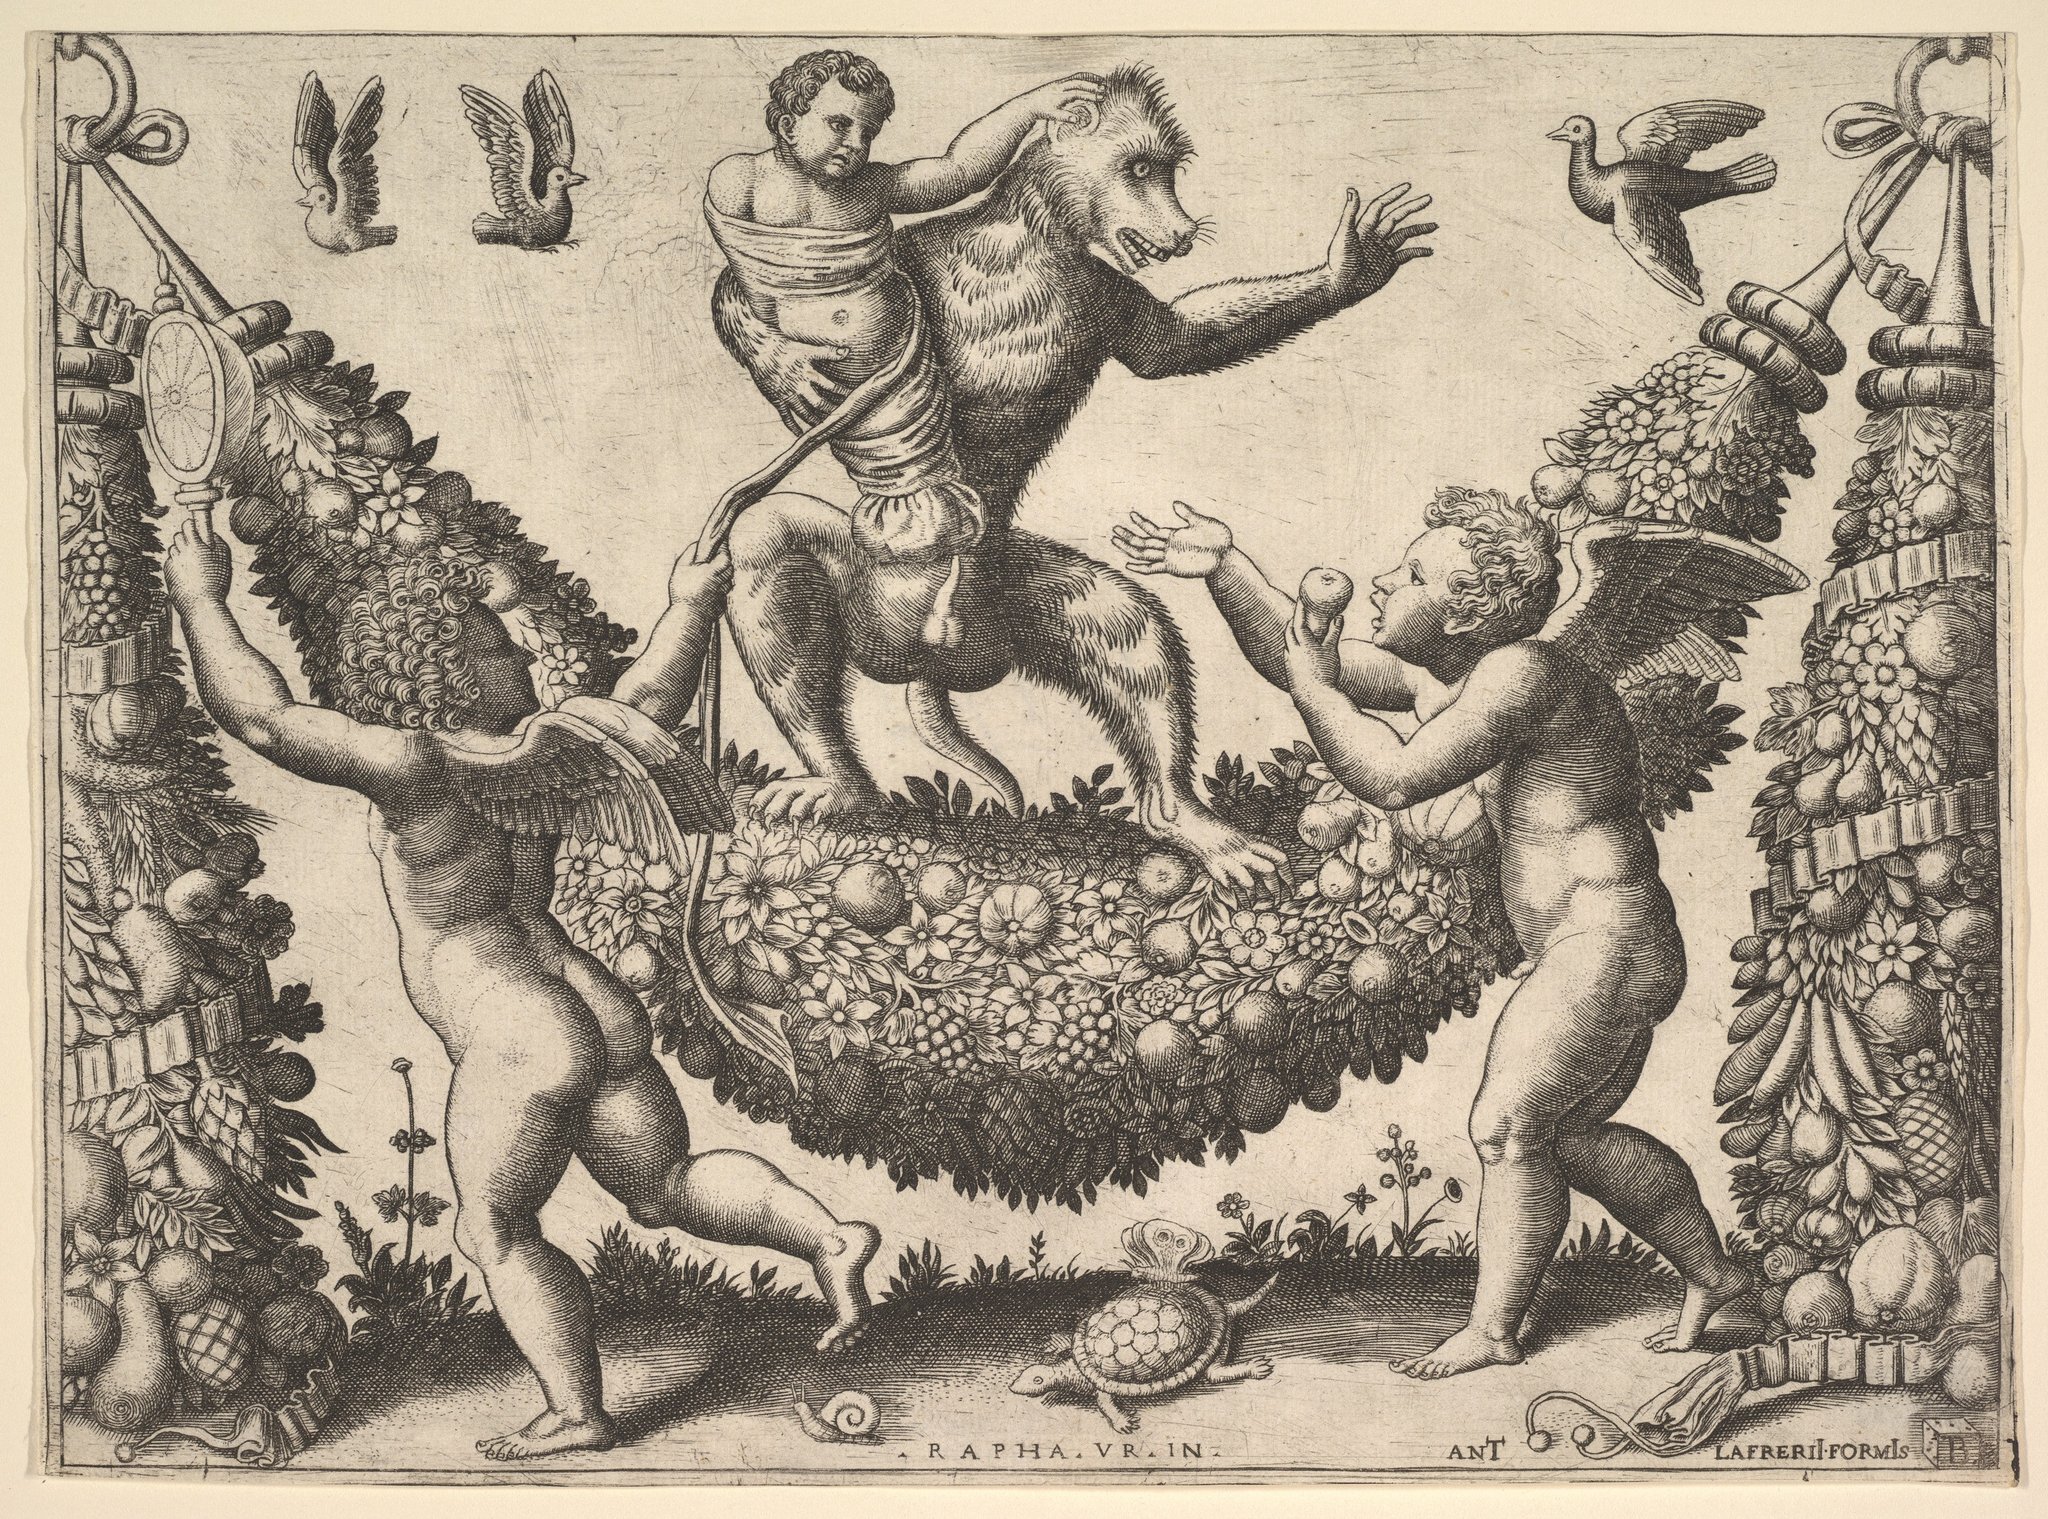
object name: print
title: A monkey holding a bound putto standing on a garland in front of which are two winged putti, from a series of tapestries made for Leo X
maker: master of the die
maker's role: artist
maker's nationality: italian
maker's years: 1525-1560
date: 1530-1560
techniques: engraving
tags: birds,garlands,putti,monkeys,turtles